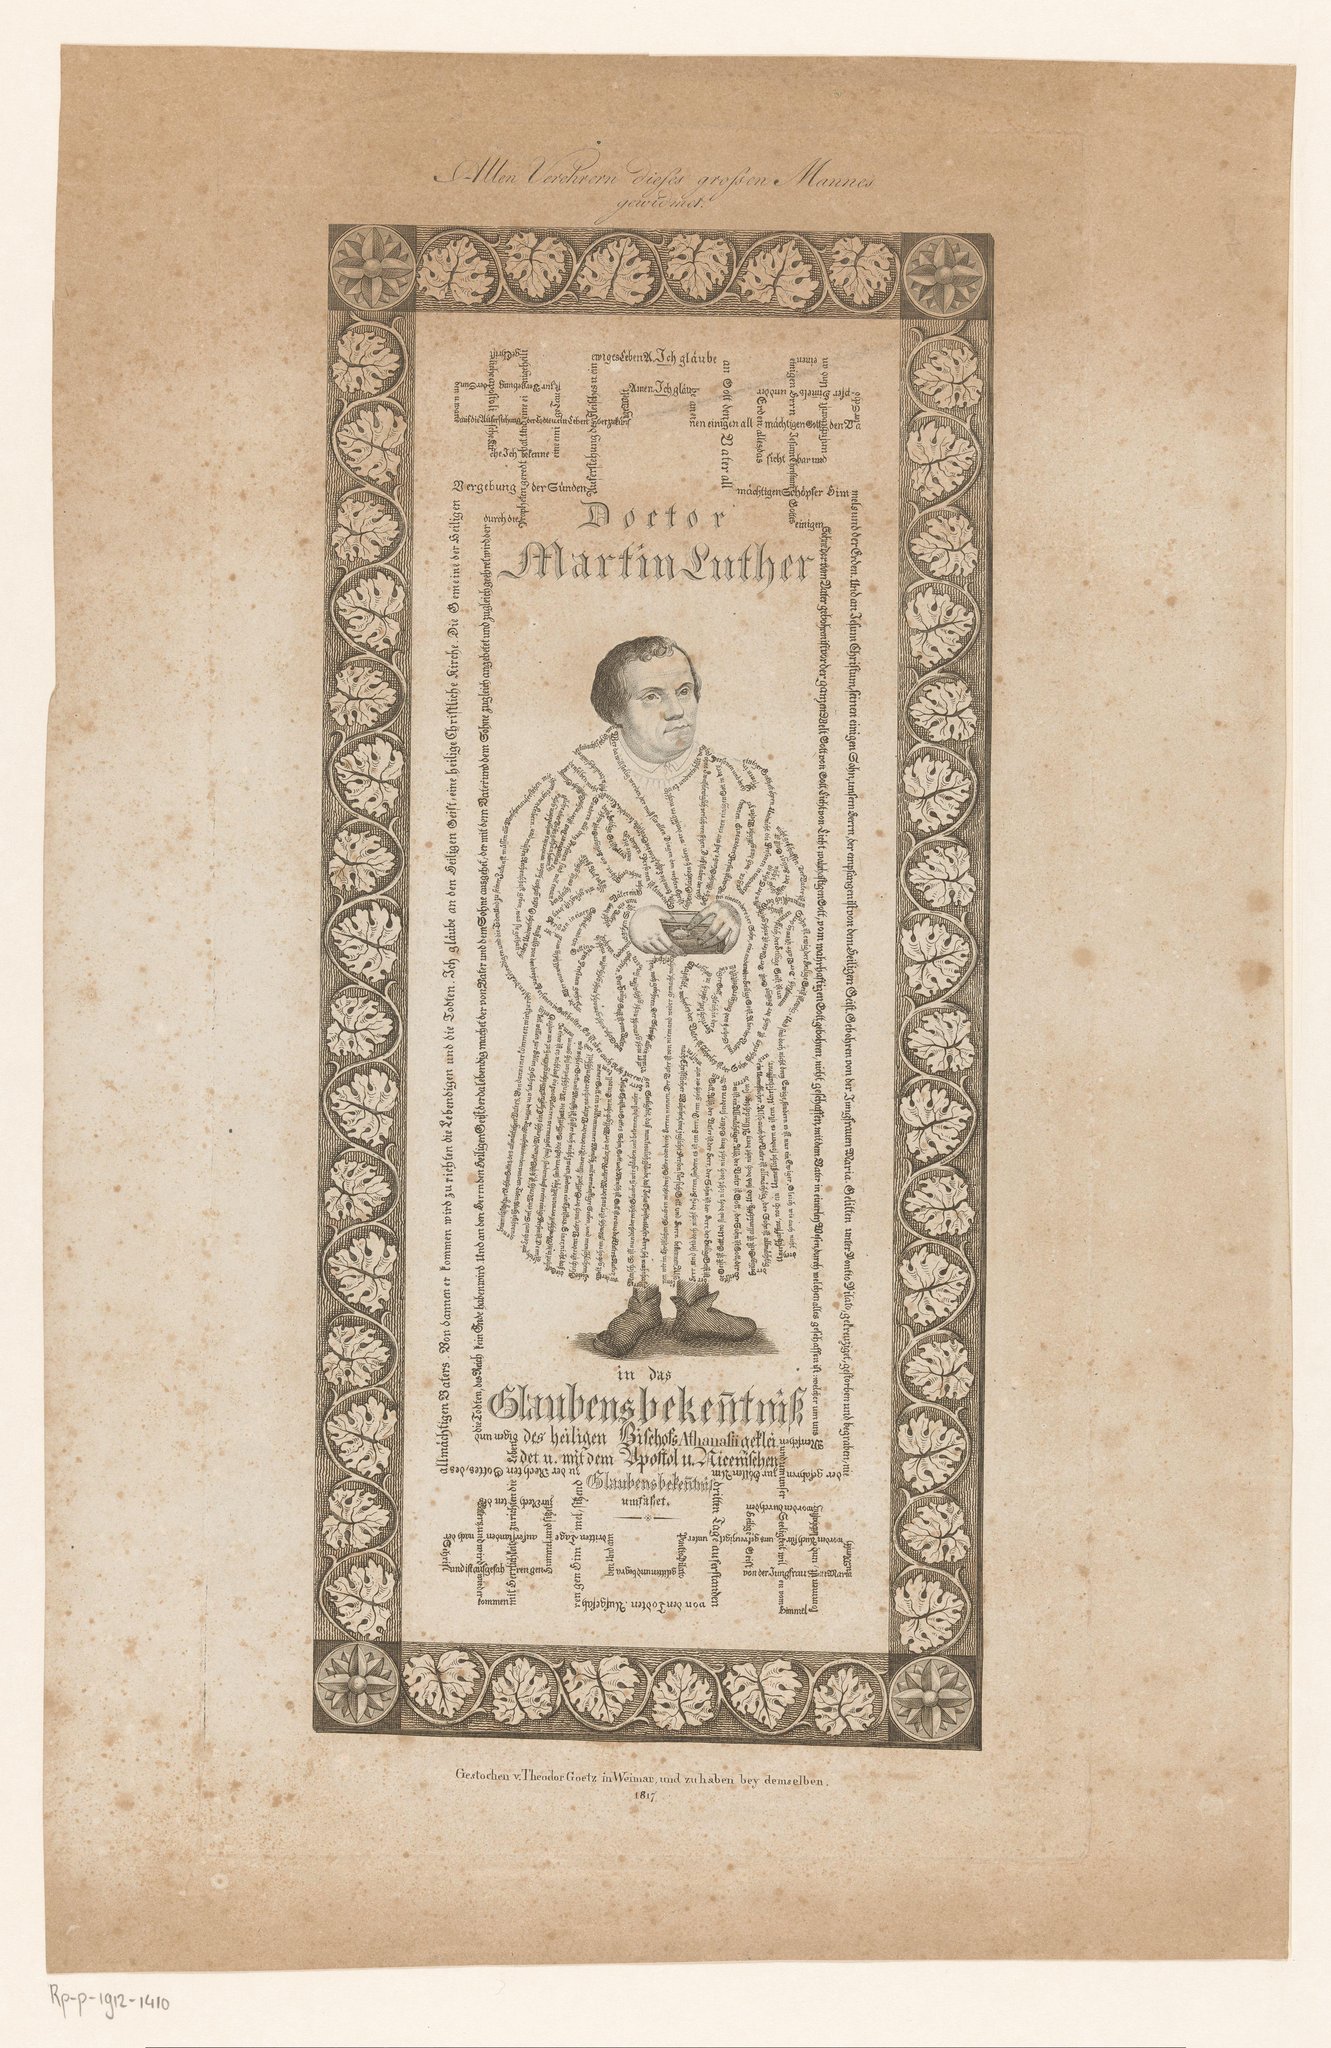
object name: print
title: Portret van Martin Luther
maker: theodor götz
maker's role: painter, print maker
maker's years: 1779-1853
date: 1817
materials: paper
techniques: engraving, etching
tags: priest, martin luther, acanthus ~ ornament, historical persons, book, writing and letters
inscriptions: collector's mark: Lugt 2228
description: De kleding van Luther en omringende decoratie bestaan uit de doorlopende tekst van de geloofsbelijdenis.